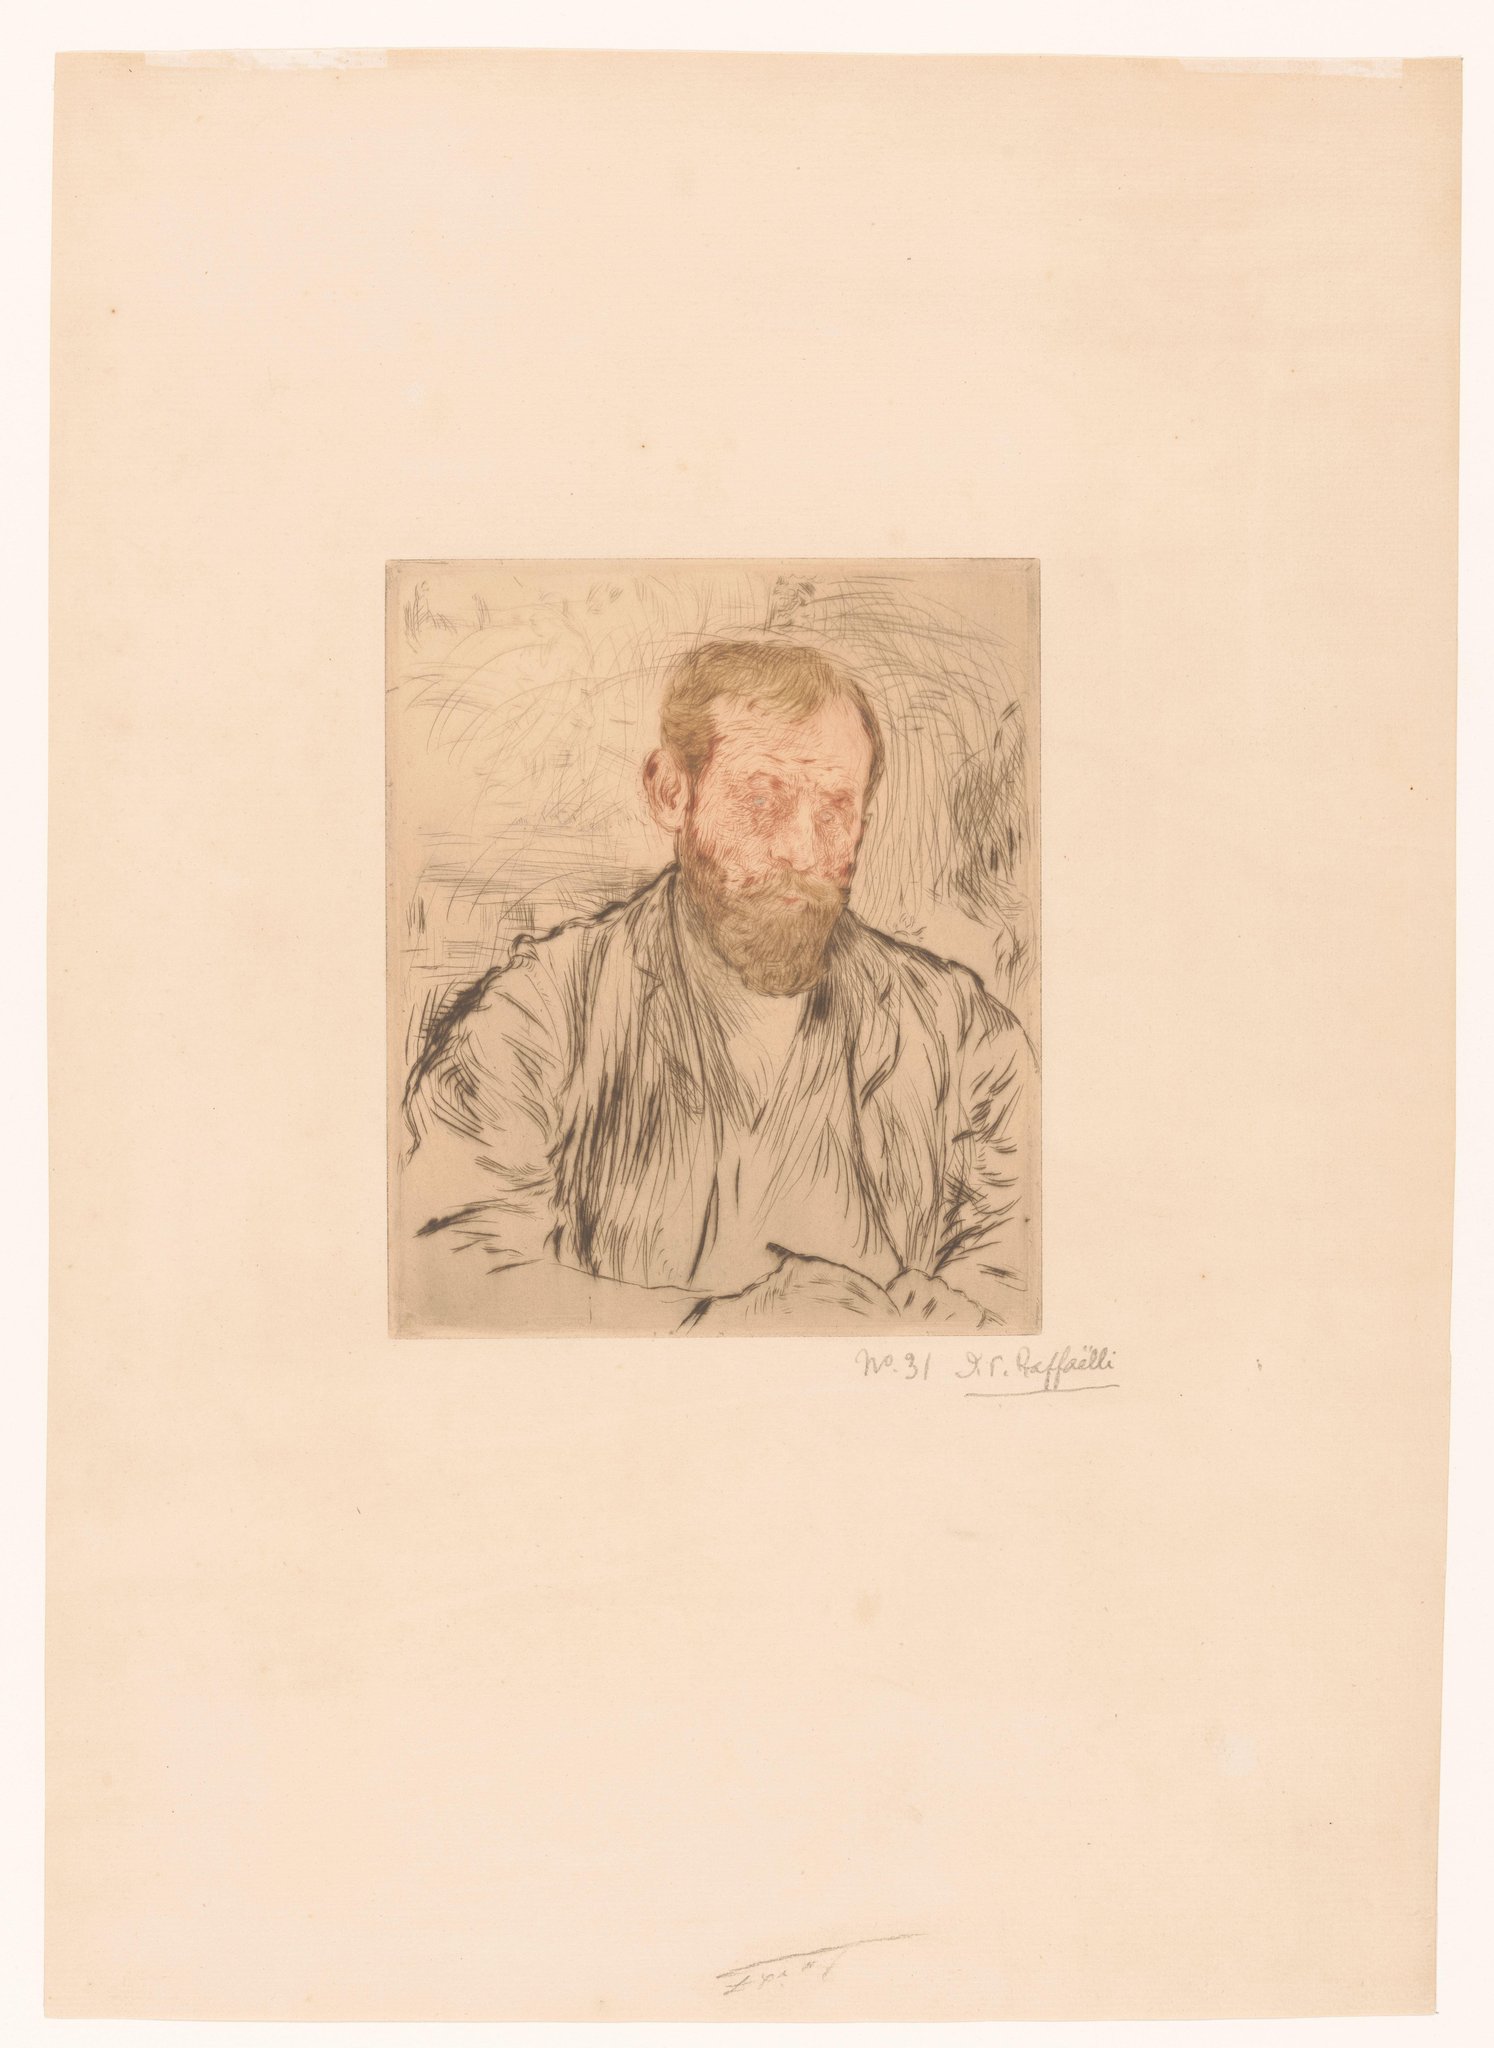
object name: print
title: Zelfportret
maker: jean françois raffaëlli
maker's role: print maker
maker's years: 1850-1924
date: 1893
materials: paper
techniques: drypoint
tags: paris, print maker, jean françois raffaëlli, portrait, self-portrait of graphic artist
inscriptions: collector's mark: Lugt 2760, collector's mark: Lugt 2228